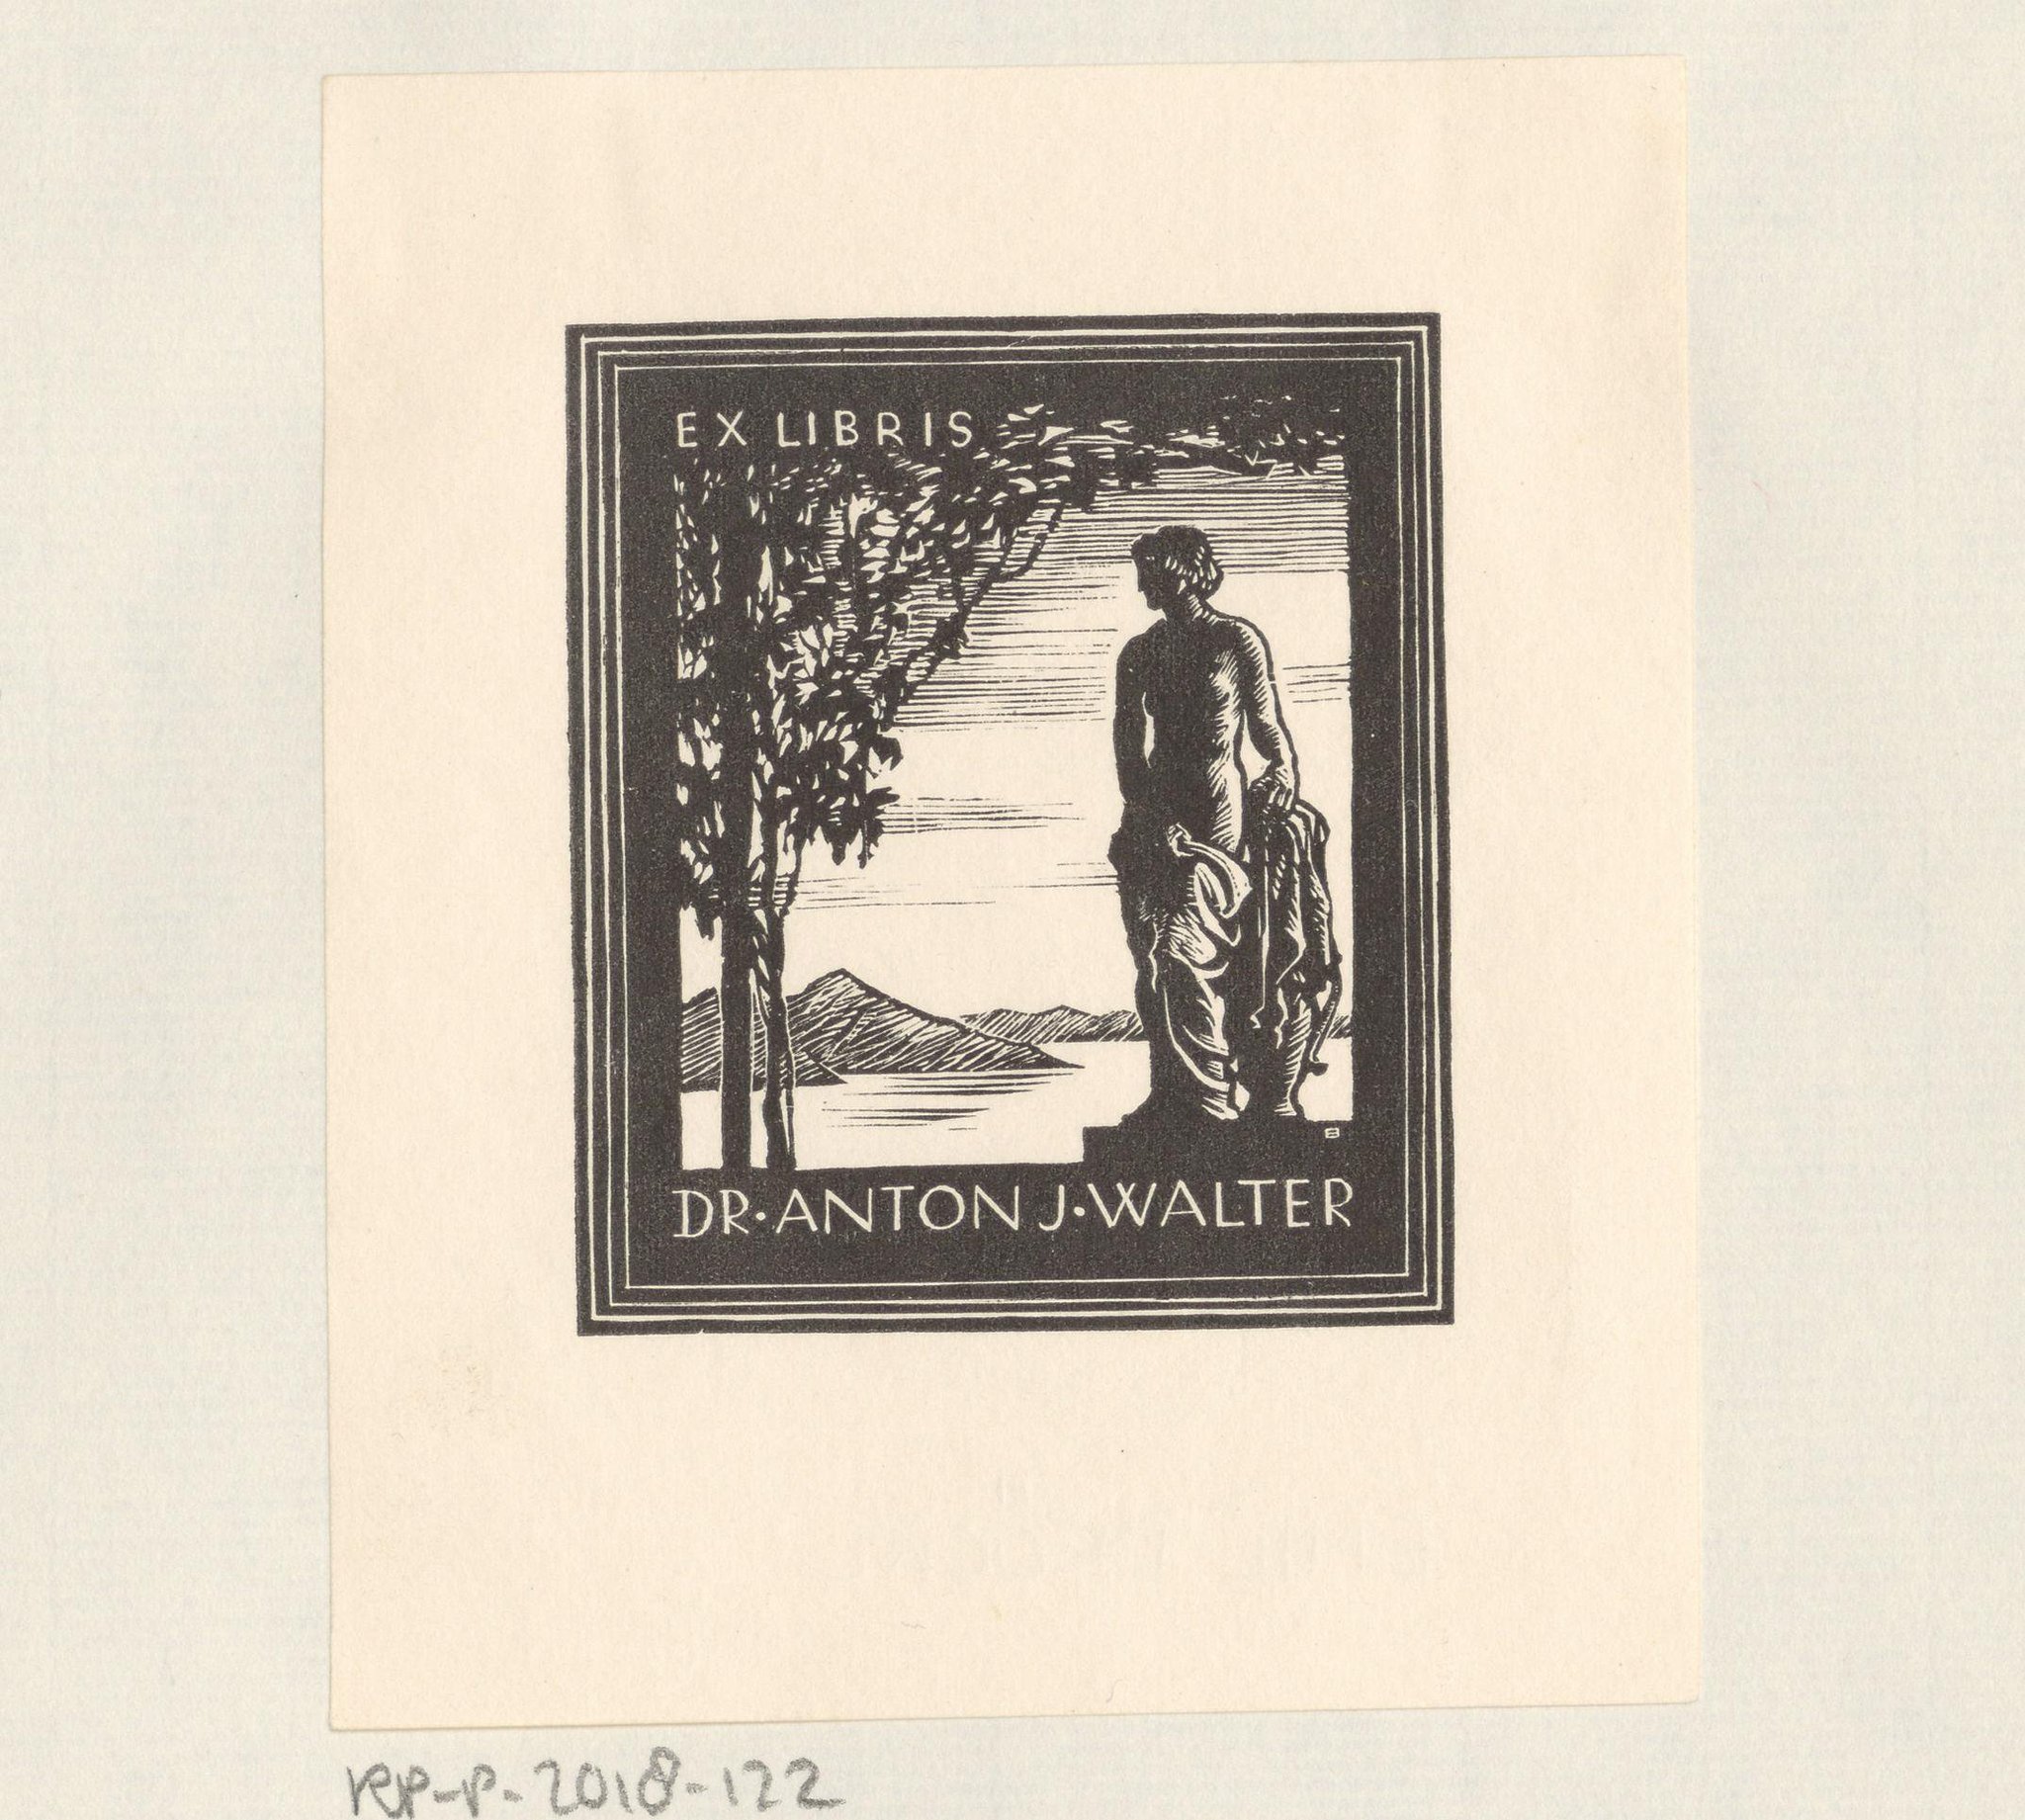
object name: bookplate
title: Ex libris van Anton J. Walter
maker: emil bröckl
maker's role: print maker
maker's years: 1906-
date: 1948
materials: paper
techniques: woodcut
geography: austria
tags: trees, landscapes with waters, waterscapes, seascapes (in the temperate zone), woman (showing herself) undressed, quasi-nude, sculpture